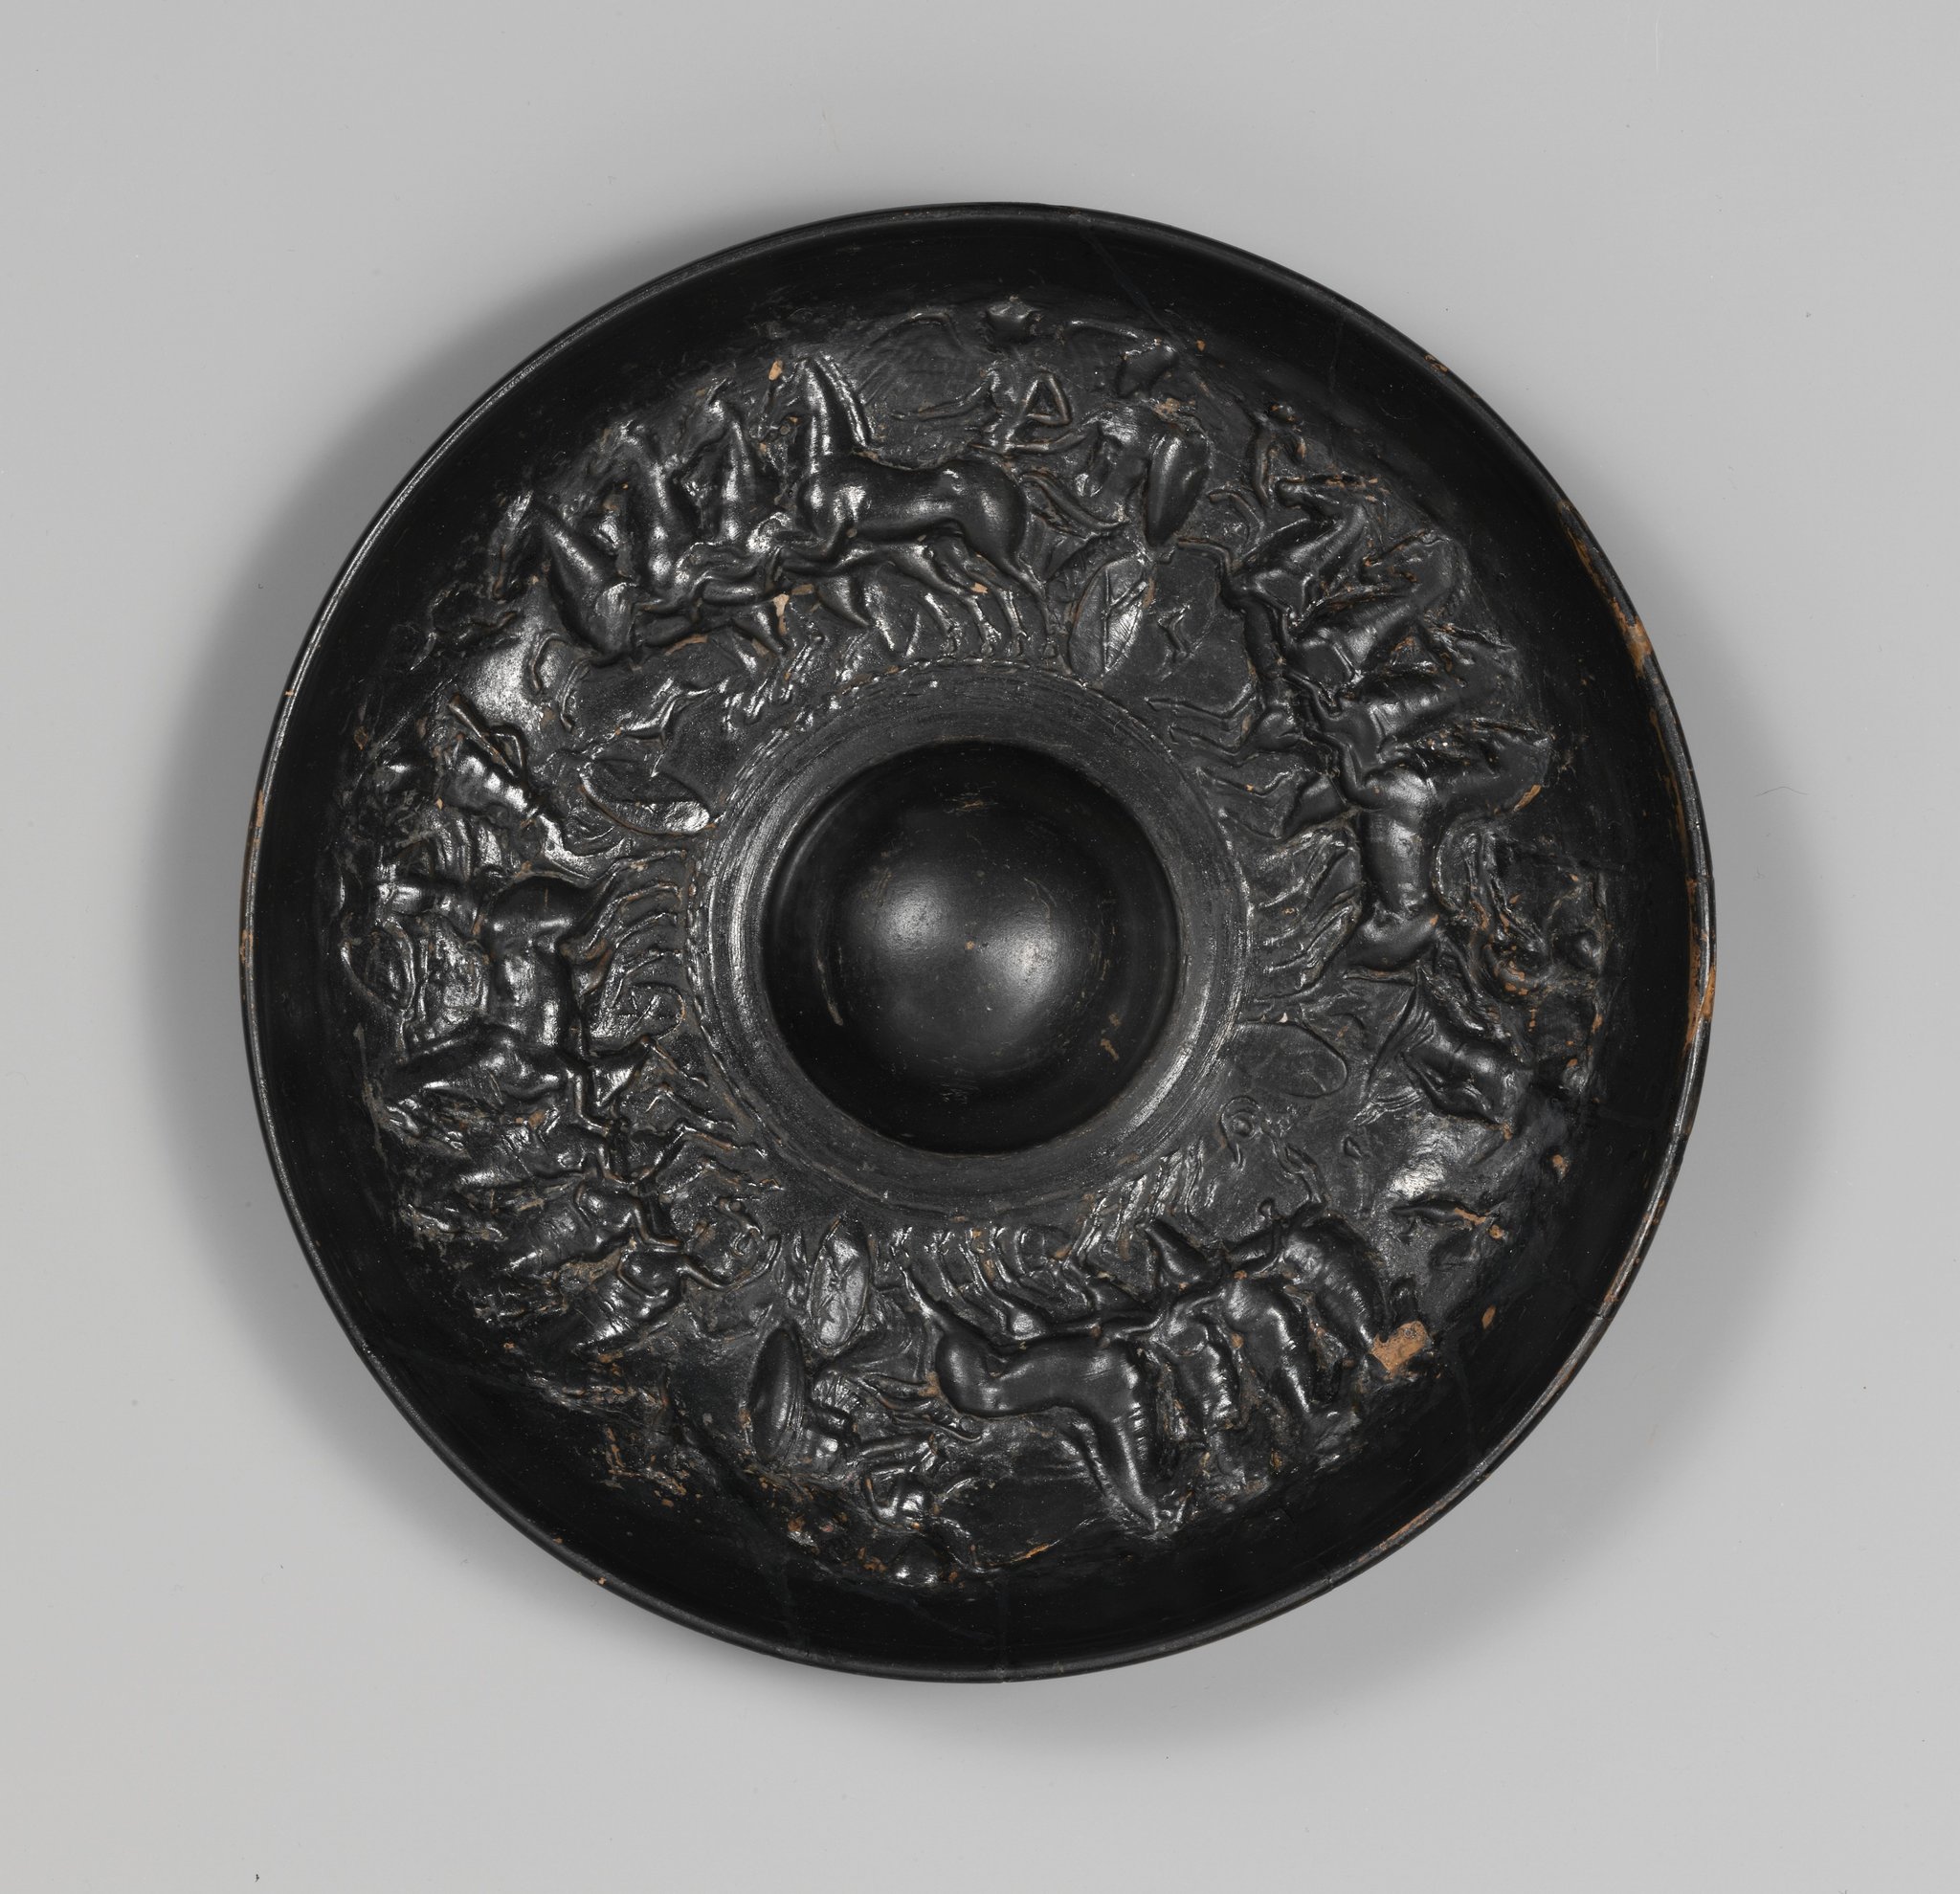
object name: phiale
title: Terracotta phiale (libation bowl)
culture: greek, calenian or campanian or south italian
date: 234-168 BCE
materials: terracotta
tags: horses,chariots